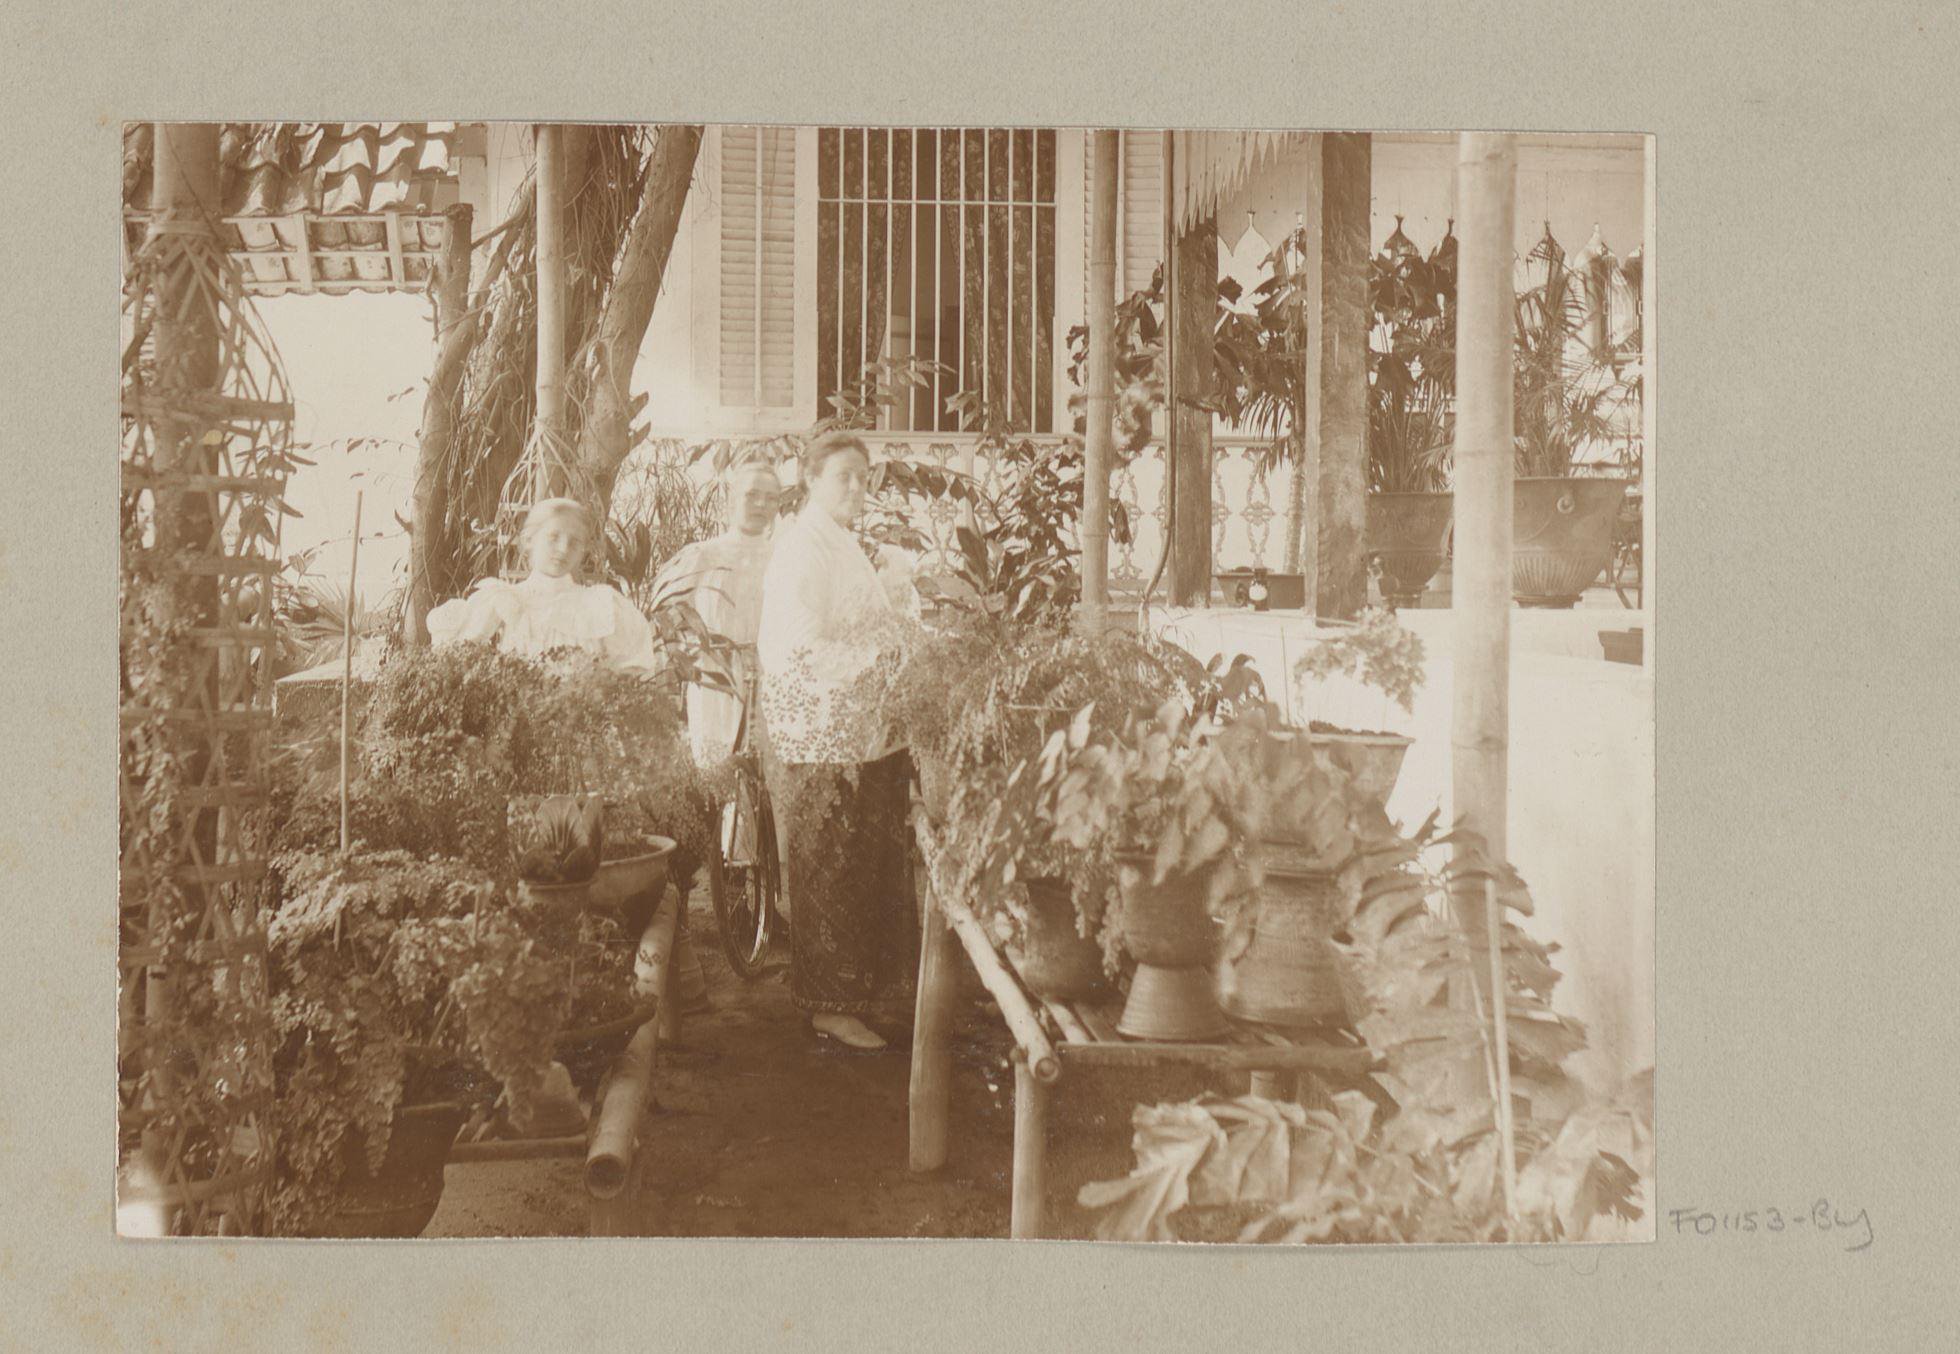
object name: photograph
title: Vrouw en kinderen omringd door planten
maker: Anonymous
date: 1880-1900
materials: photographic support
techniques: collodion silver print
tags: plants (in general), adult woman, child, dutch east indies, the